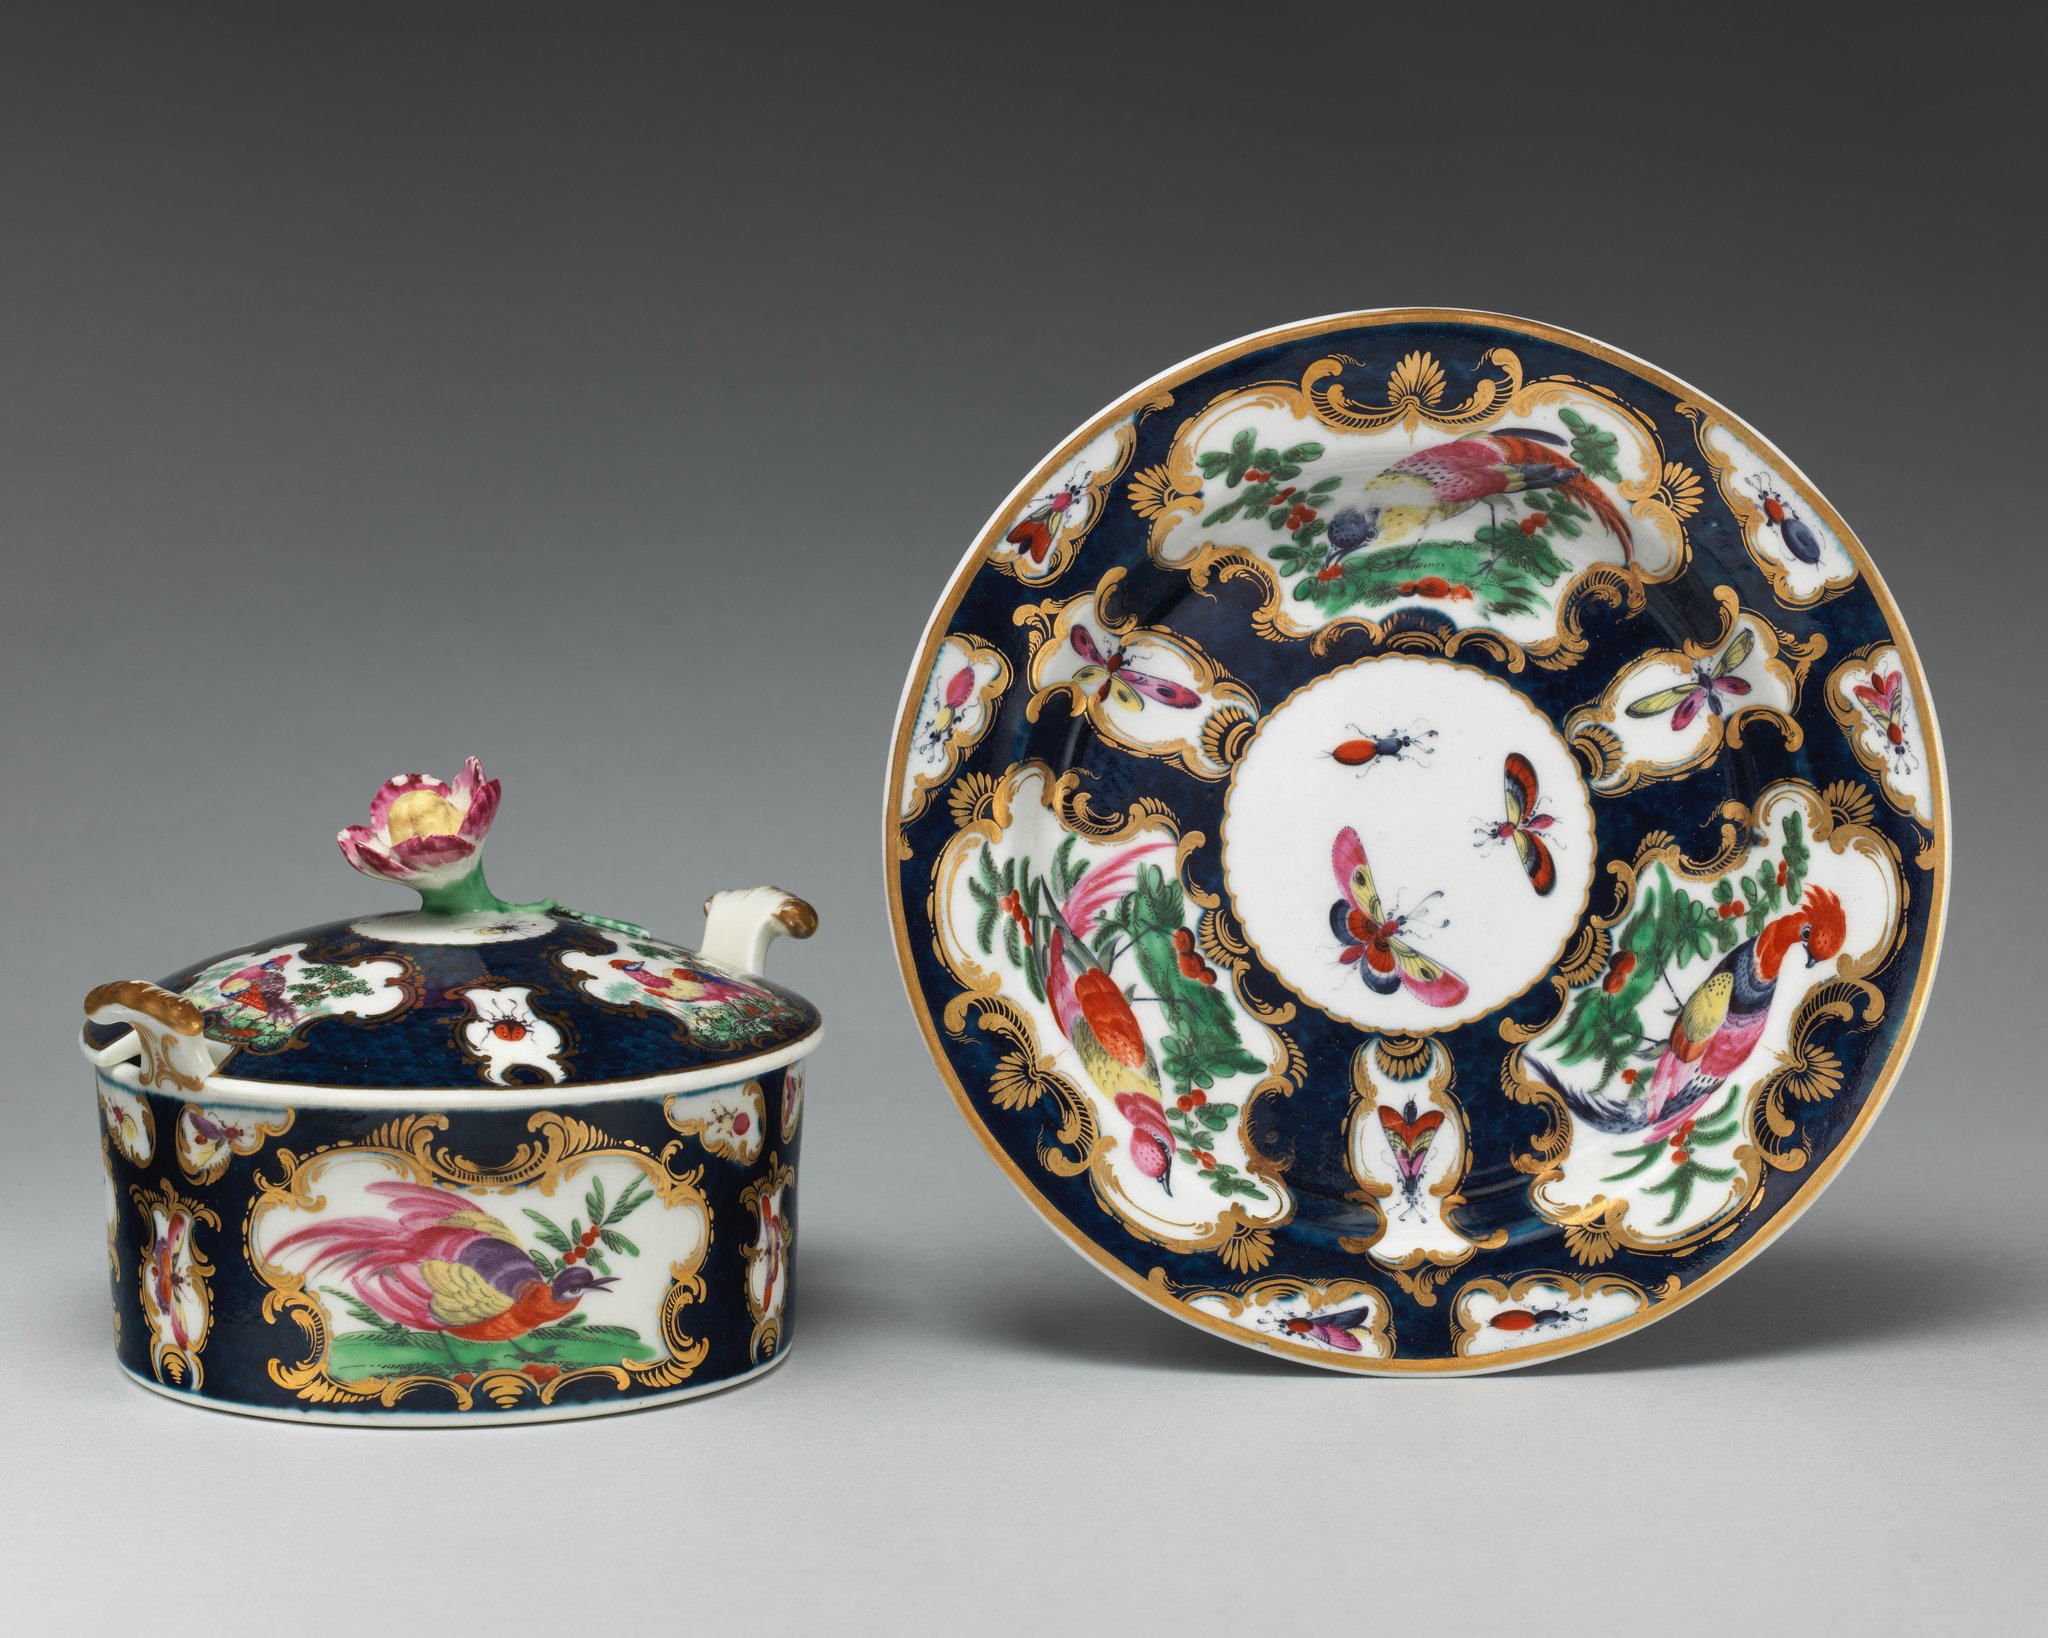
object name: butter dish with cover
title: Butter dish with cover and tray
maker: worcester factory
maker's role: factory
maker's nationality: british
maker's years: 1751-2008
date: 1770-1780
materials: soft paste porcelain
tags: birds,butterflies